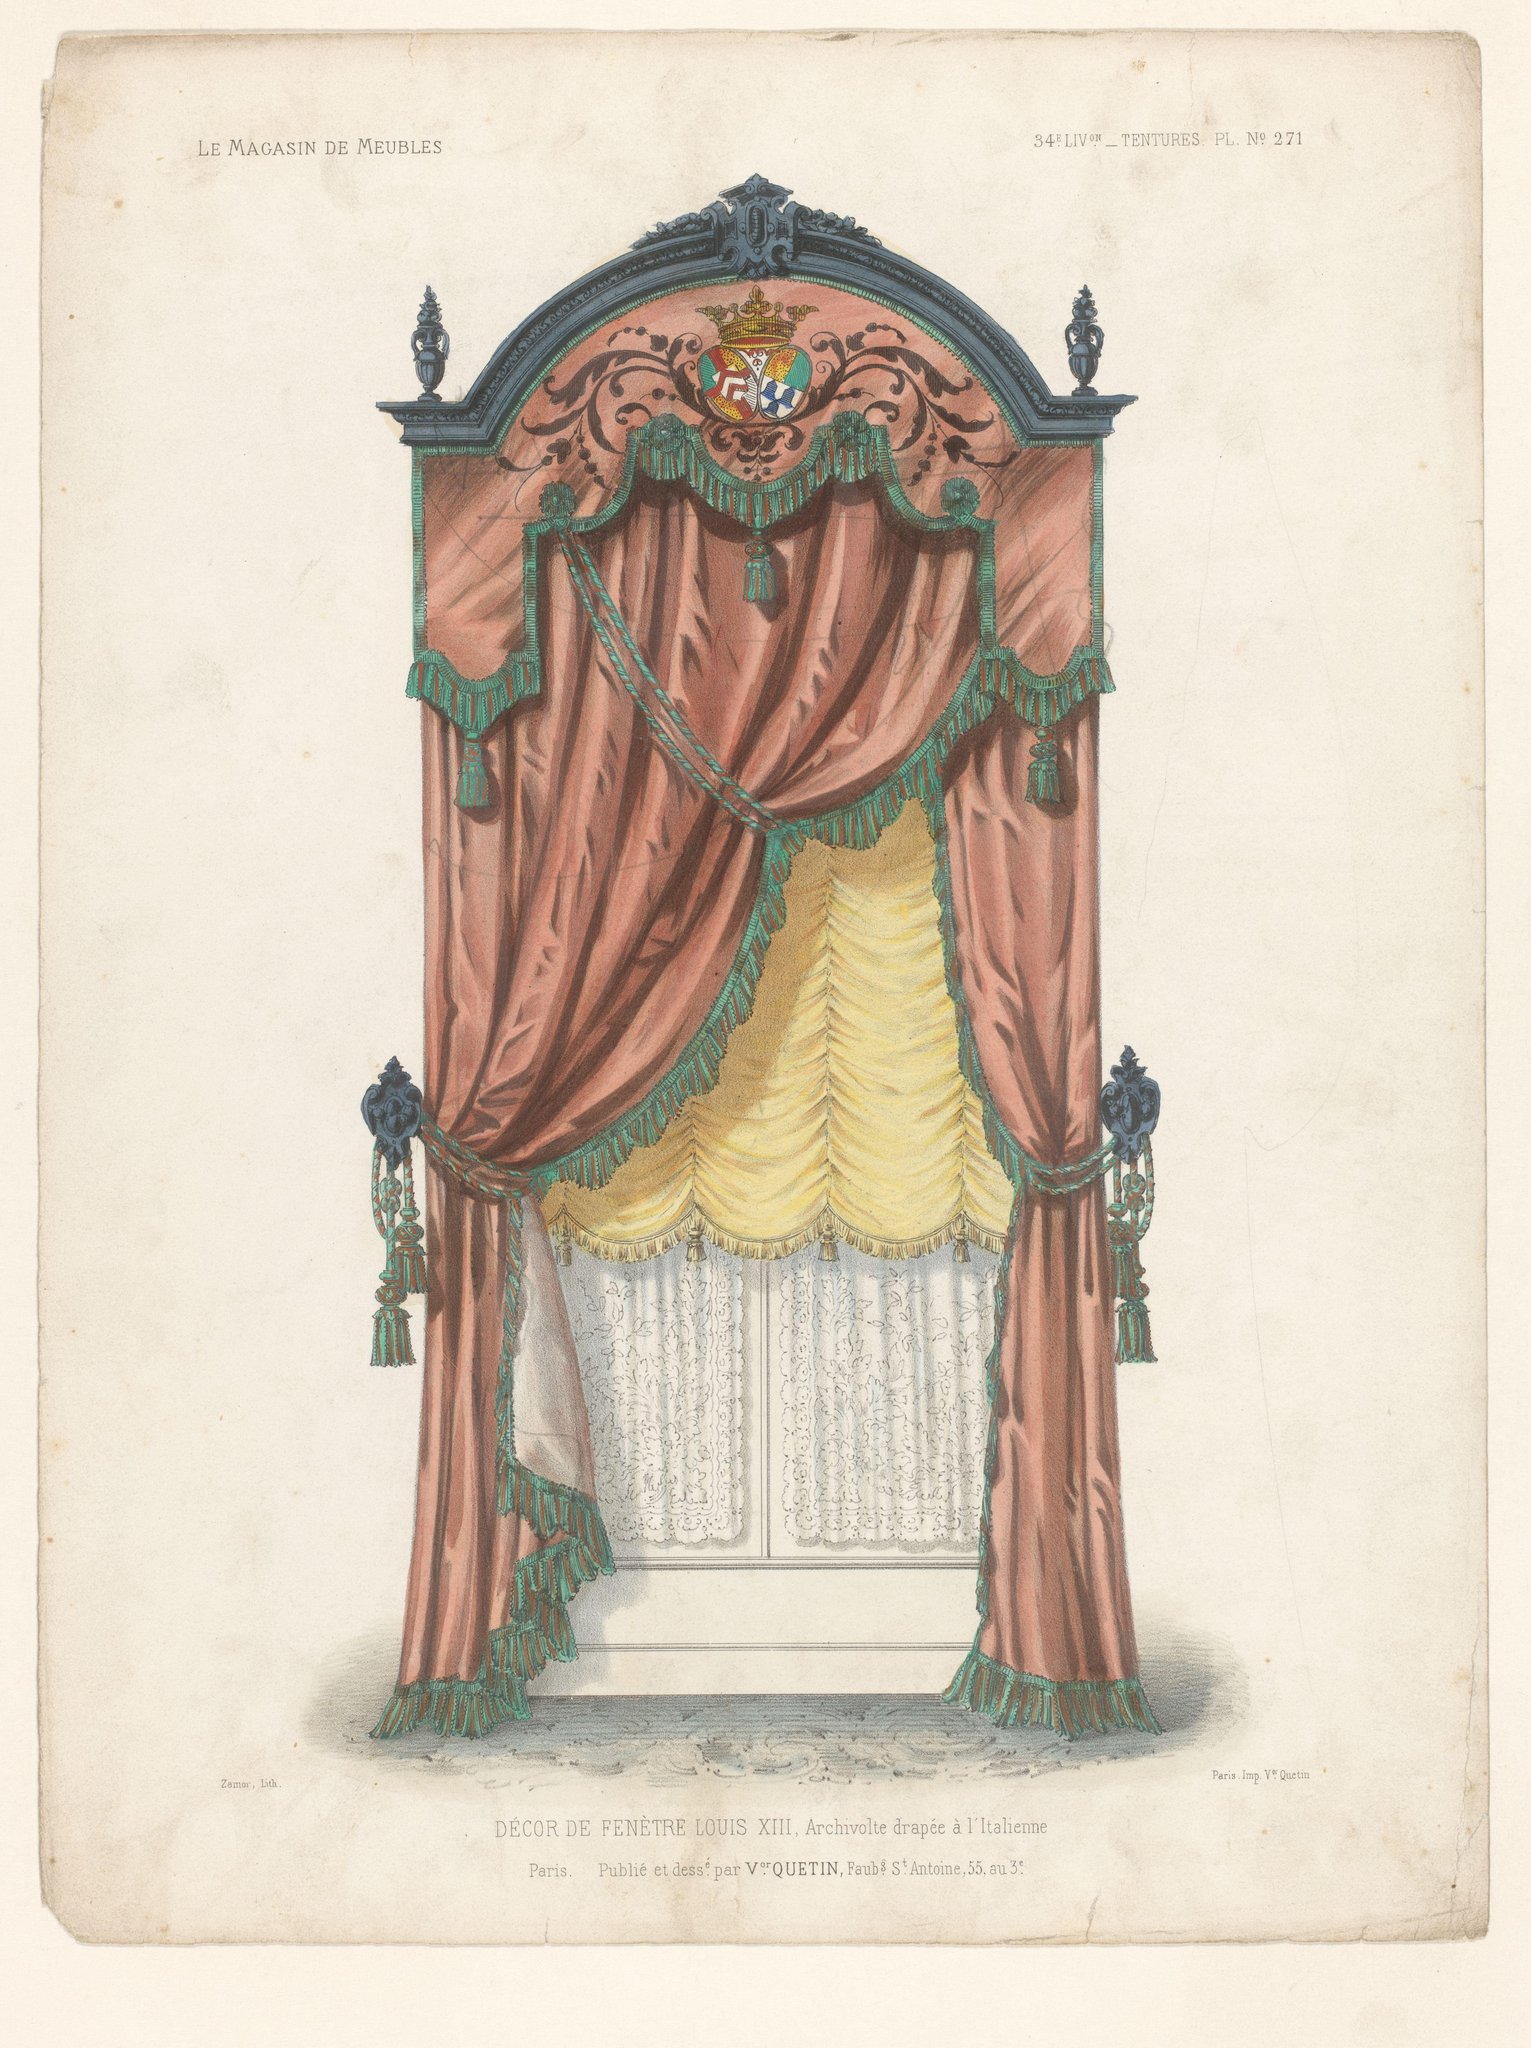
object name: print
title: Venster met gordijnen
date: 1832-1877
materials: paper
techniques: hand coloring, lithograph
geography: paris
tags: window, hangings and drapery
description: Een venster met gedrapeerde gordijnen in de Lodewijk XIII-stijl. Prent uit 34e Livraison.